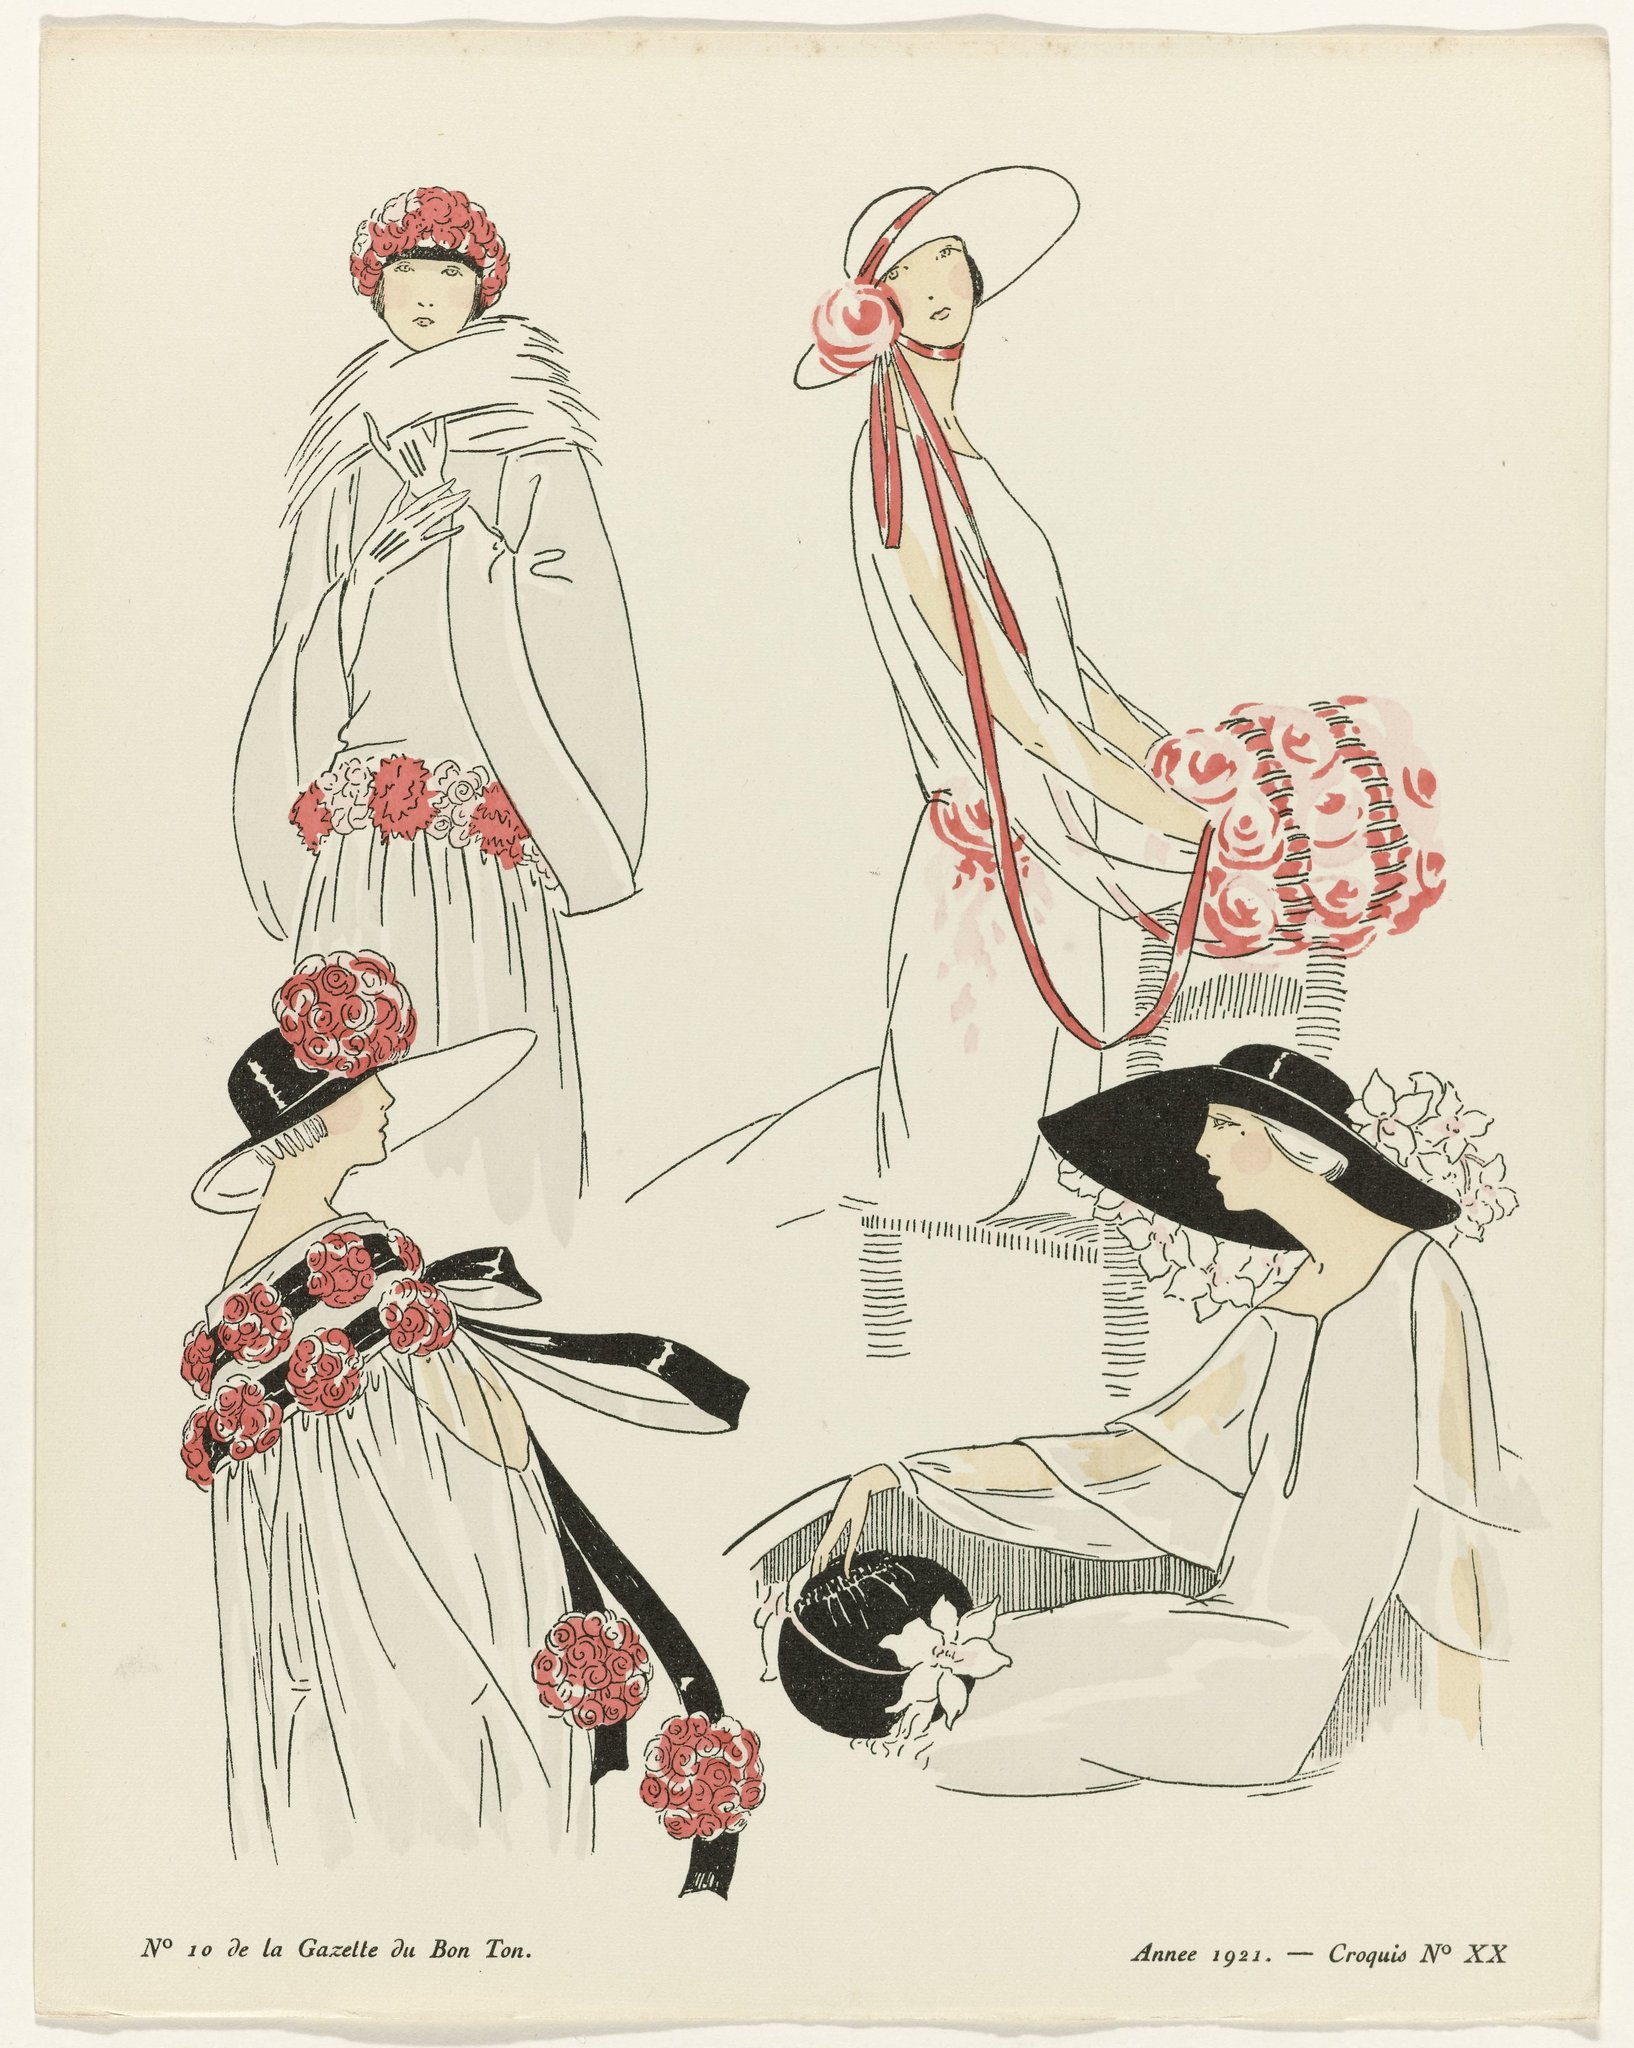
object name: fashion print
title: Gazette du Bon Ton, 1921 - No. 10: Croquis No XX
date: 1921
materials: paper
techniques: hand coloring, letterpress printing, lithograph, pochoir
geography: london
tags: border, ribbon, braid (+ women's clothes), cut flowers; nosegay, bunch of flowers (+ variant), fashion plates, head-gear: hat (+ women's clothes), dress, gown (+ women's clothes), muff (+ women's clothes)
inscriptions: date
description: Vier vrouwen in jurken voor aan het strand, versierd met echte bloemen en verschillende modellen hoeden. Croquis No XX uit een serie van acht schetsen: "Pour la Riviera robes garnies de fleurs naturelles, dans la mesure où l'on en a et où l'on ne préfère pas d'employer, moins coûteuses, les fleurs artificielles." uit Gazette du Bon Ton 1921, No. 10.